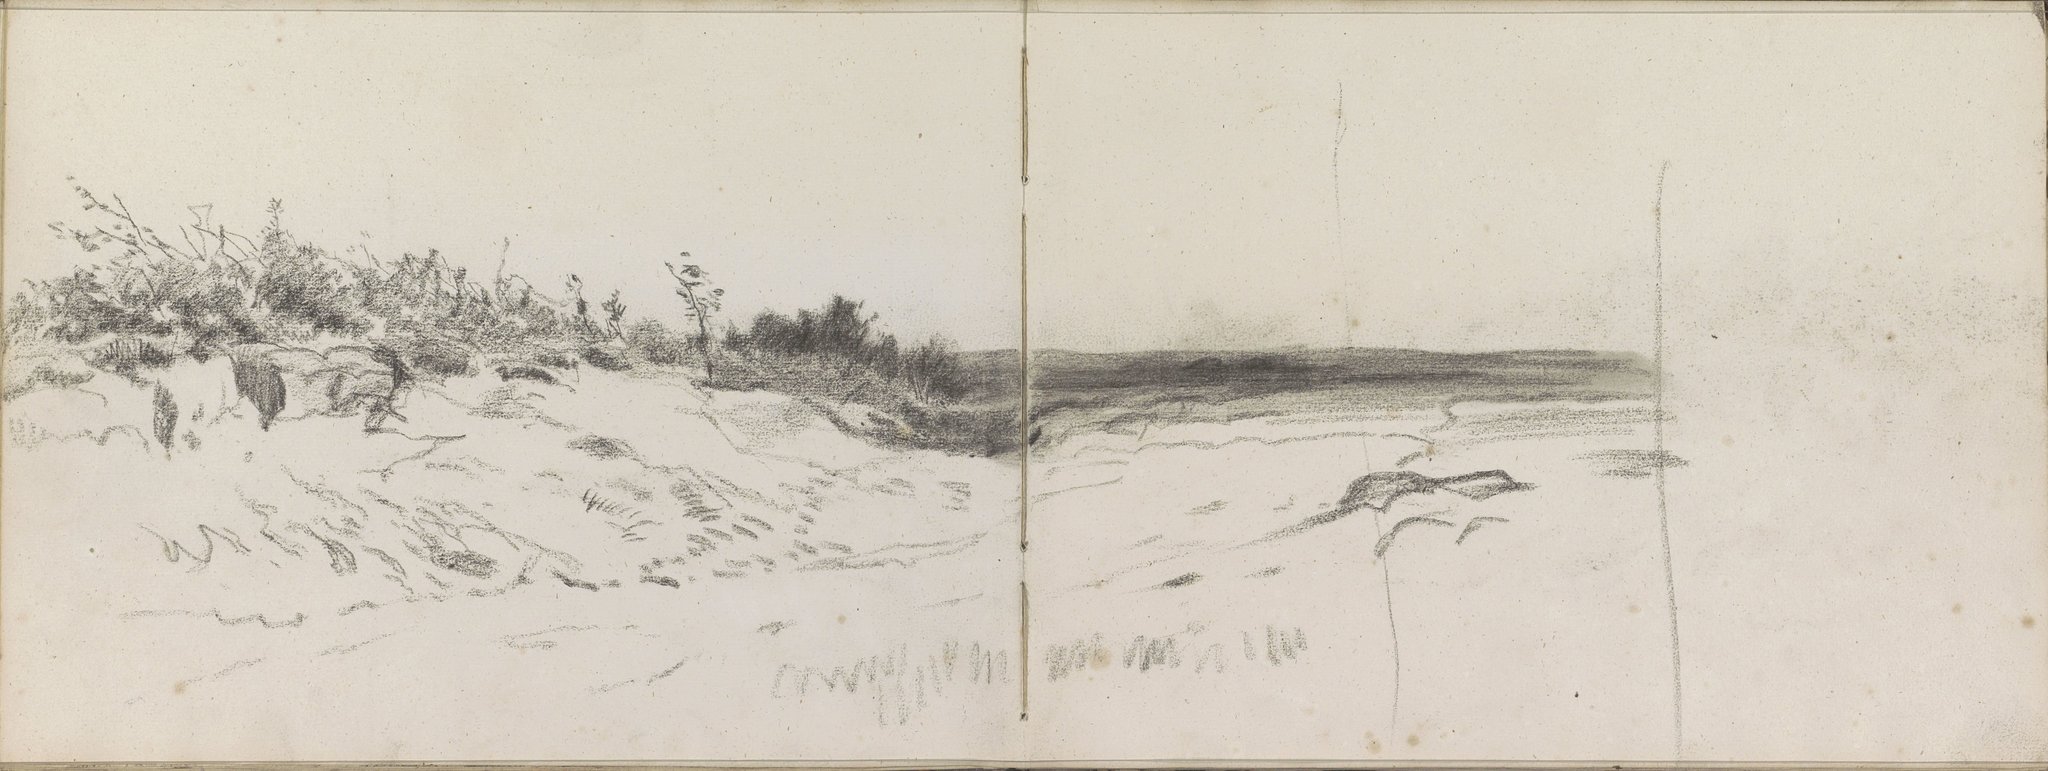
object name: sketchbook leaf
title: Landschap met planten en struiken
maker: anton mauve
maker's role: draughtsman, painter, print maker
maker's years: 1838-1888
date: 1848-1888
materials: chalk, paper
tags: landscapes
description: Blad 3 verso en 4 recto uit een schetsboek met 34 bladen.